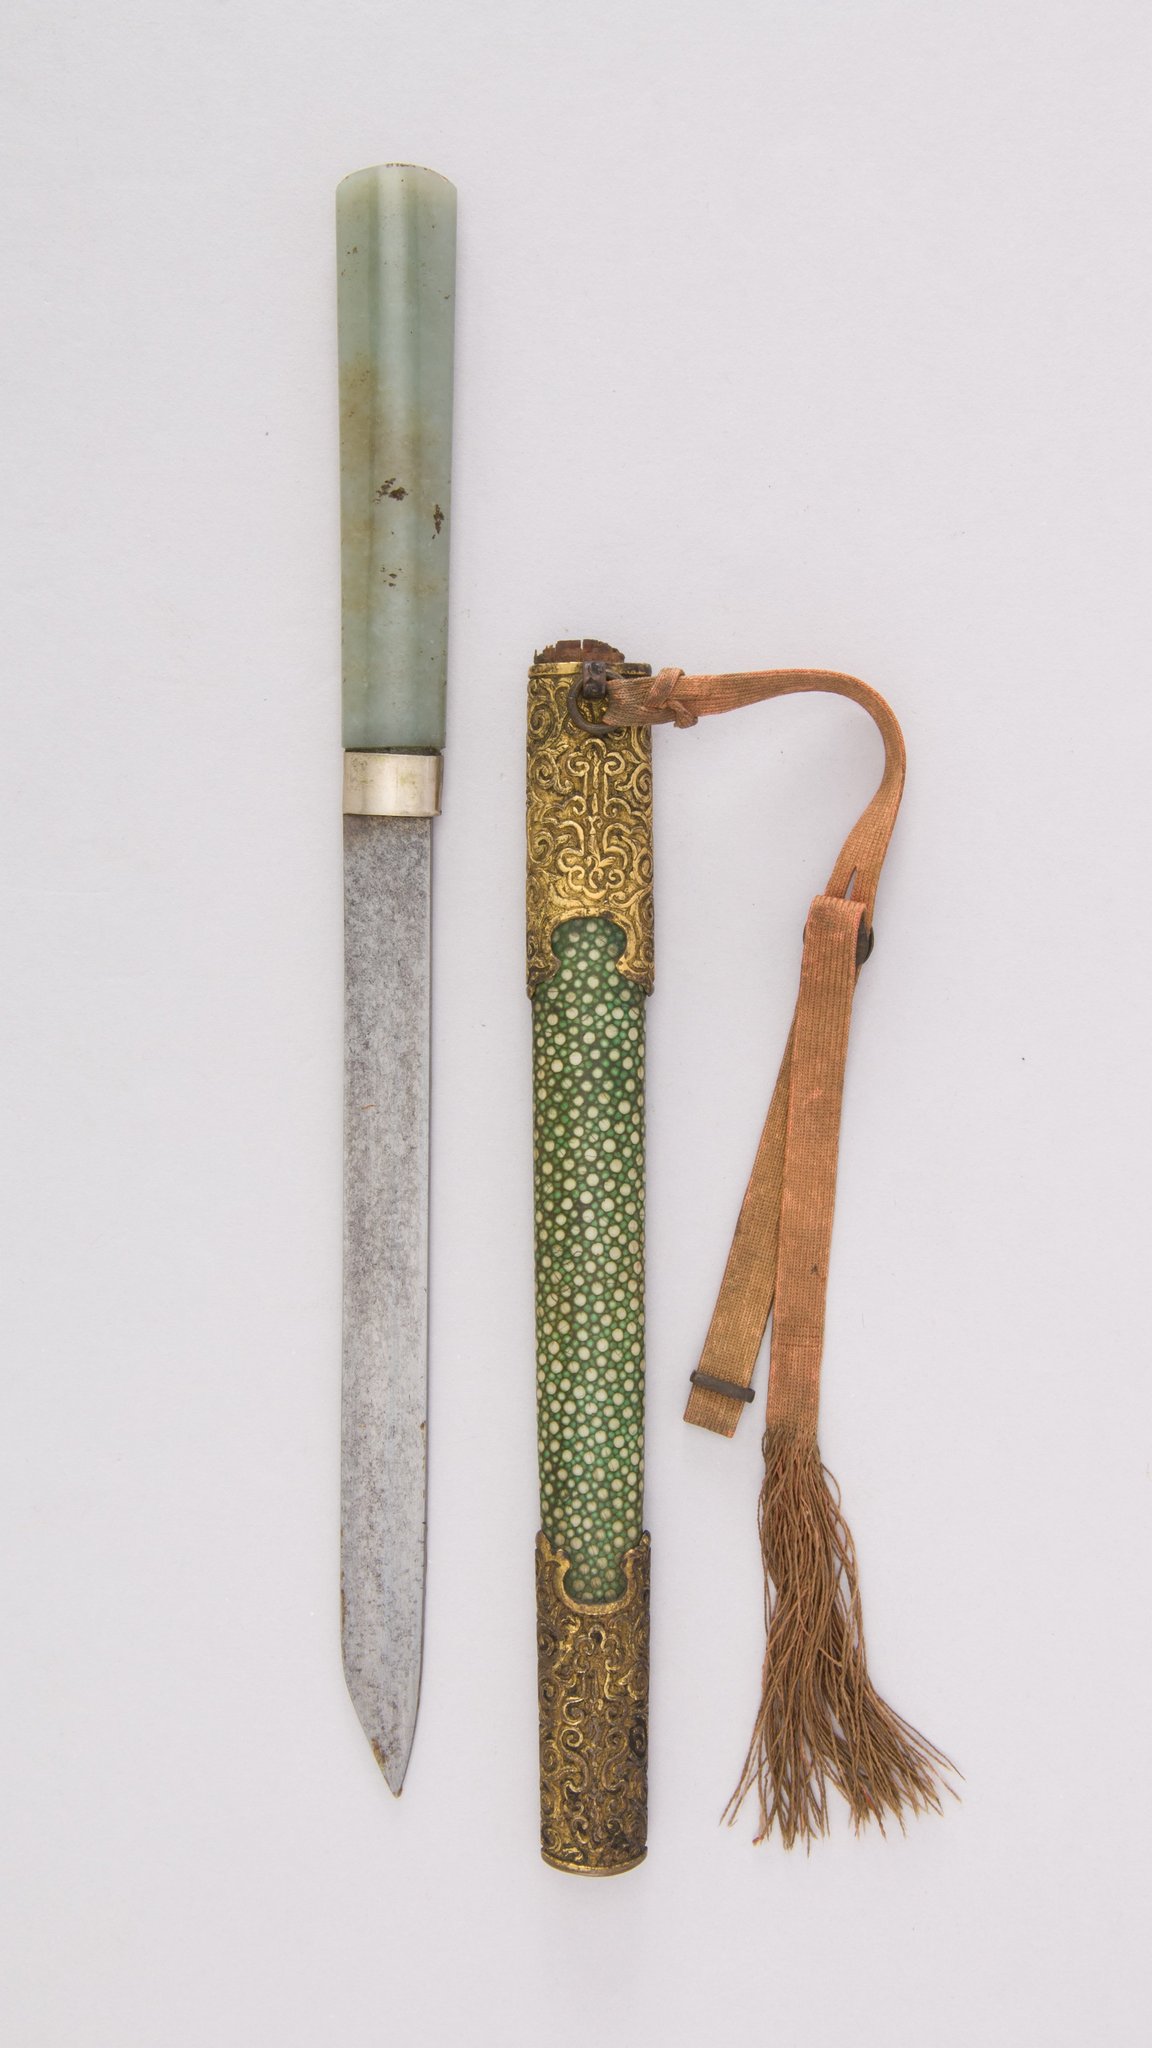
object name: knife with sheath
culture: chinese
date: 1701-1900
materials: brass, gold, jade, skin, steel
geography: china